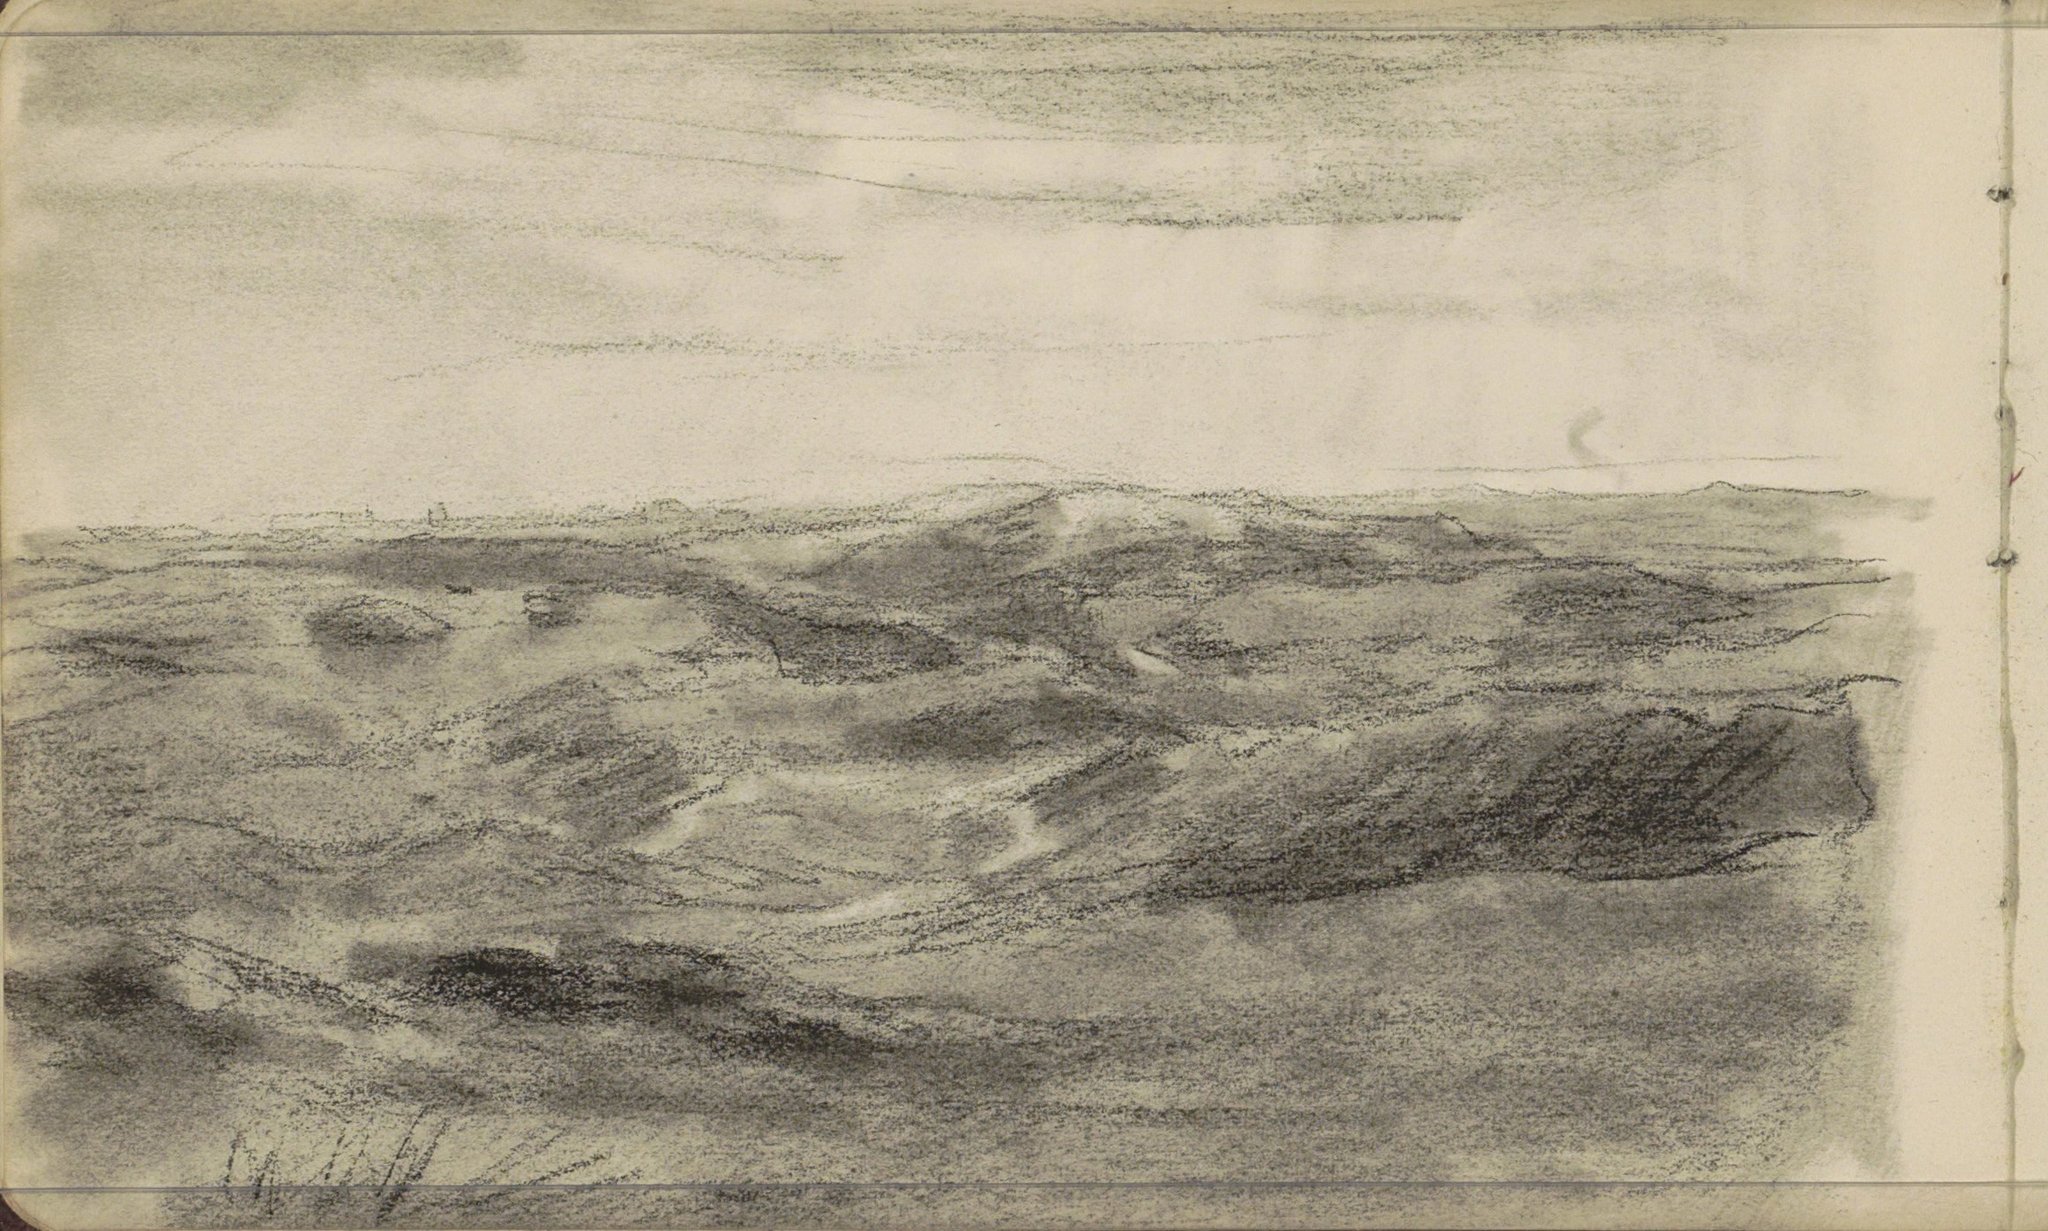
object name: sketchbook leaf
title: Landschap, mogelijk een duinlandschap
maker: johan antonie de jonge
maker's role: draughtsman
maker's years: 1864-1927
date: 1881-1927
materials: chalk, paper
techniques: stumping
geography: south holland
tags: dune coast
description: Landschap, mogelijk een duinlandschap. Blad 5 verso uit een schetsboek met 34 bladen.